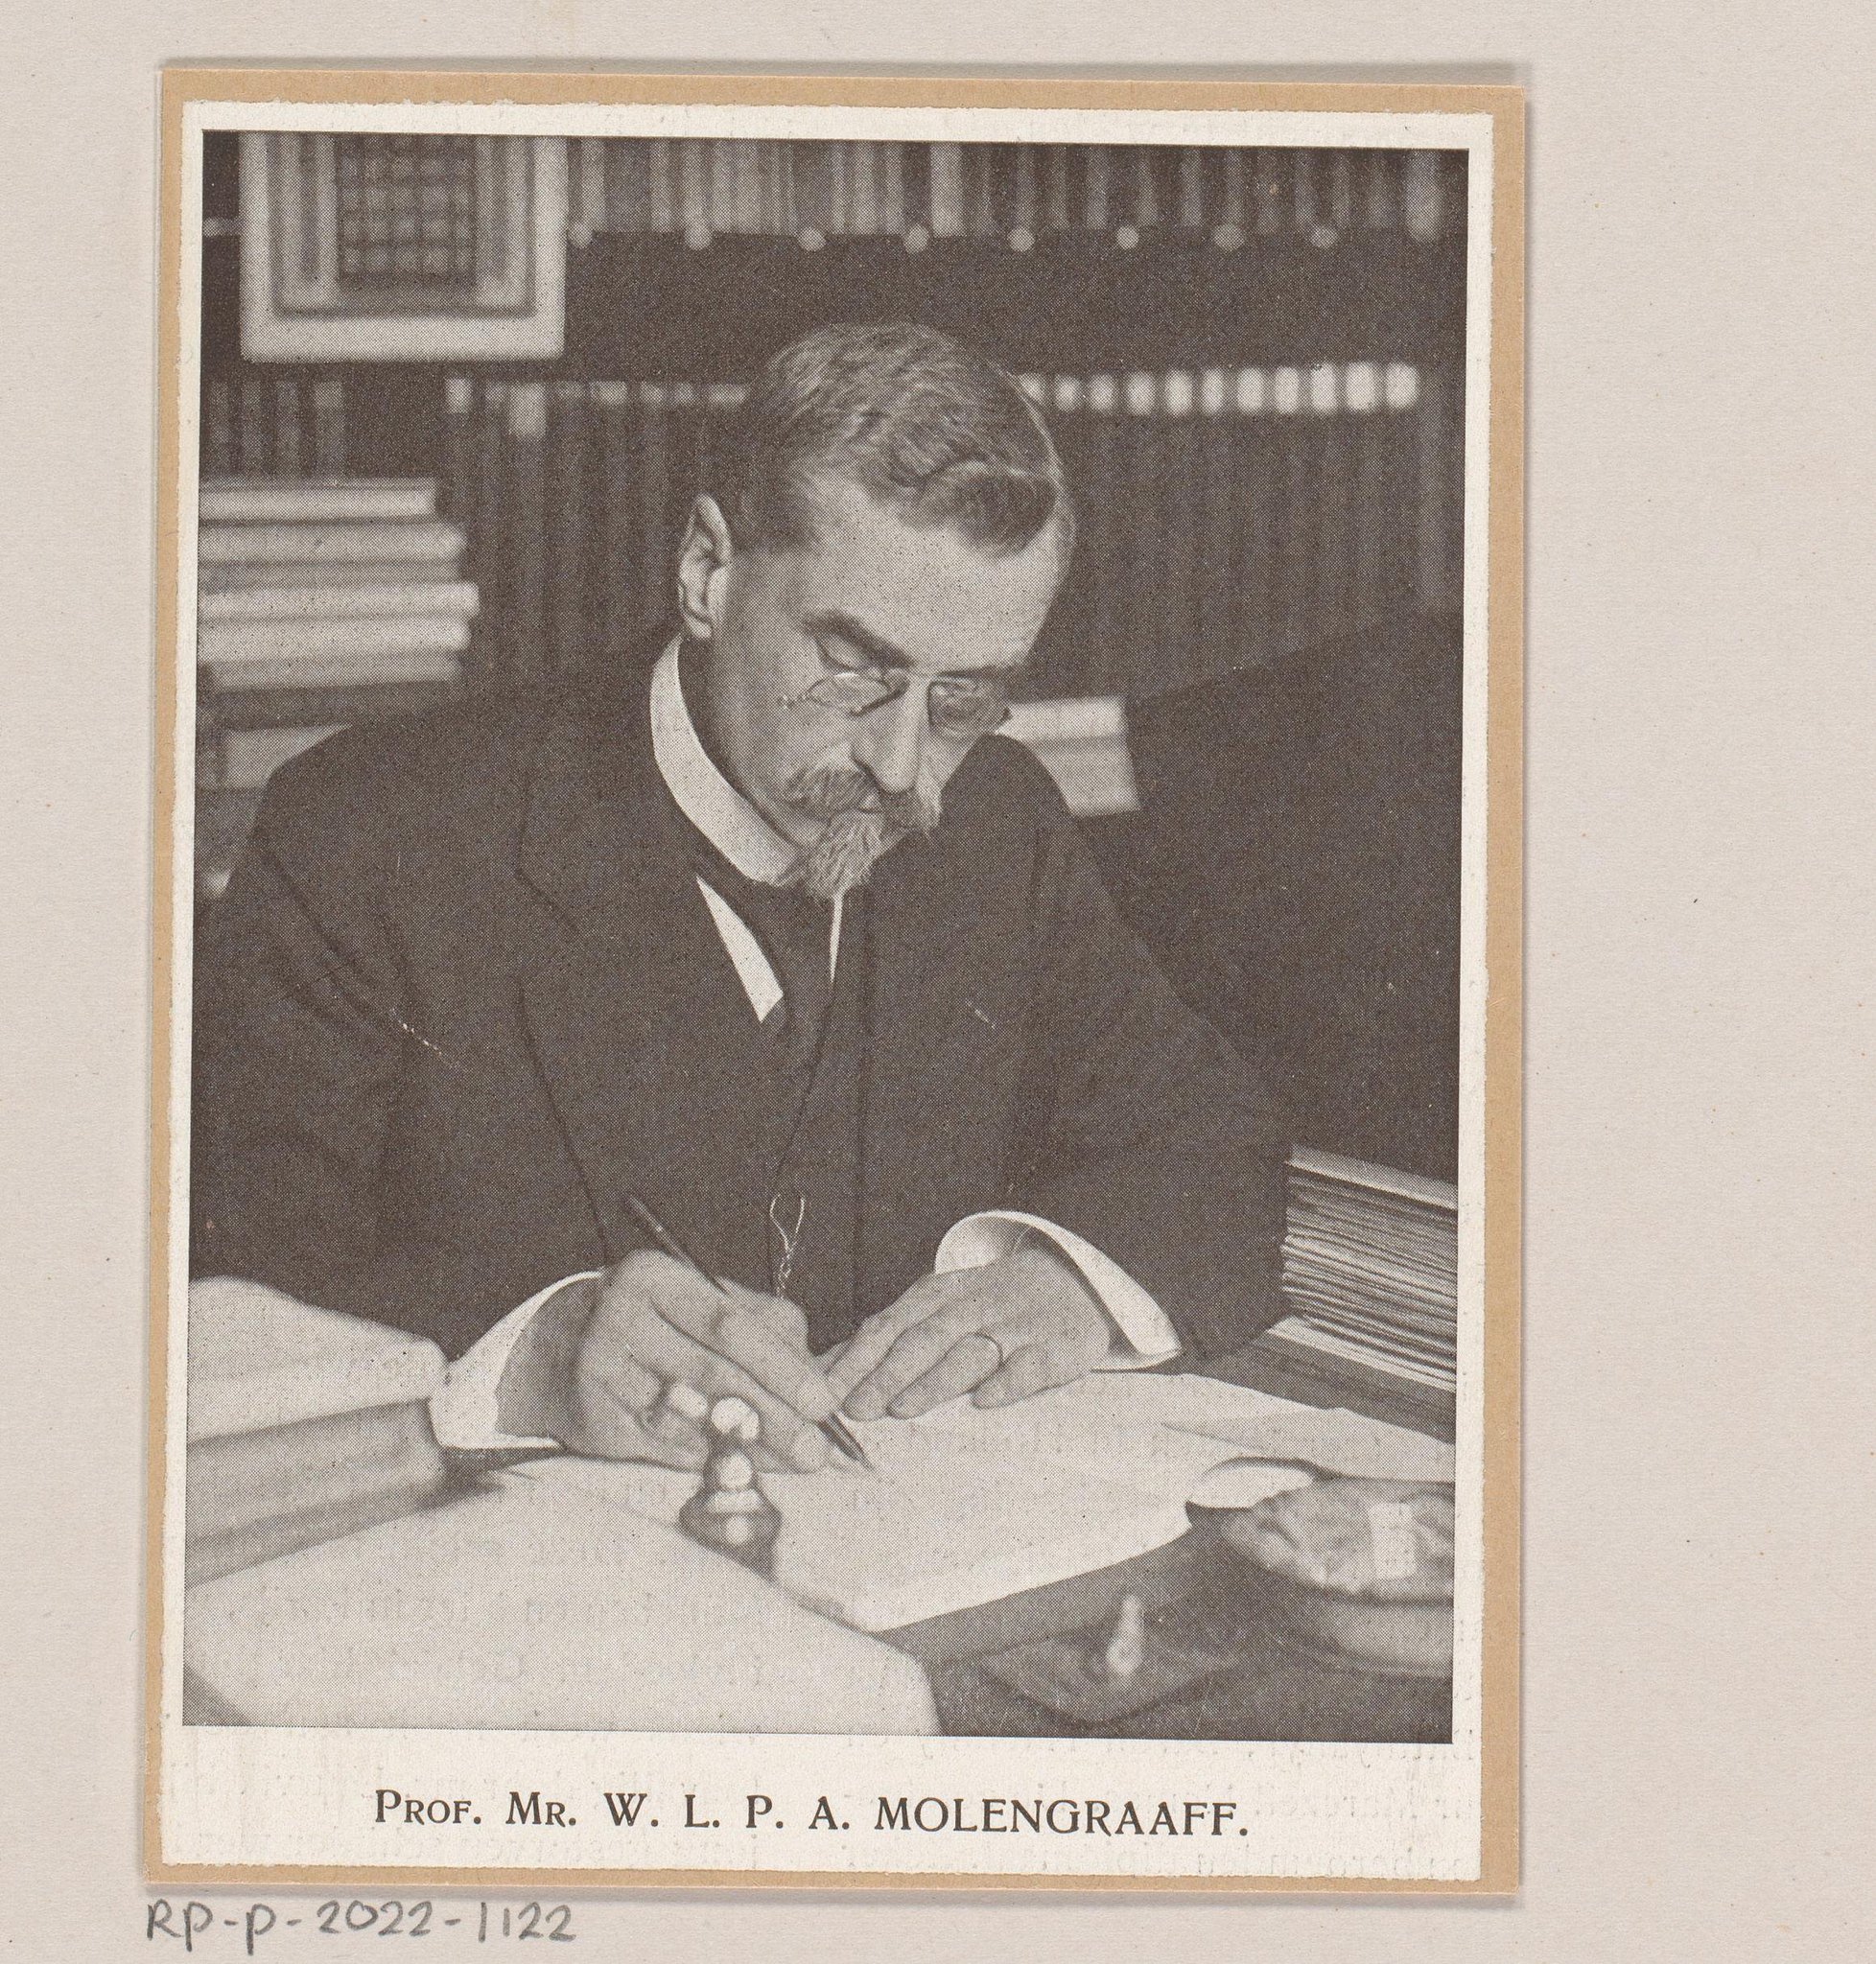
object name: photomechanical print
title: Portret van Willem Molengraaff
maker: Anonymous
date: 1898-1970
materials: cardboard, paper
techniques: letterpress printing, snipping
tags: nijmegen, the hague, historical persons, lawyer, attorney at law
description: Fotomechanische afdruk uit een onbekende publicatie.